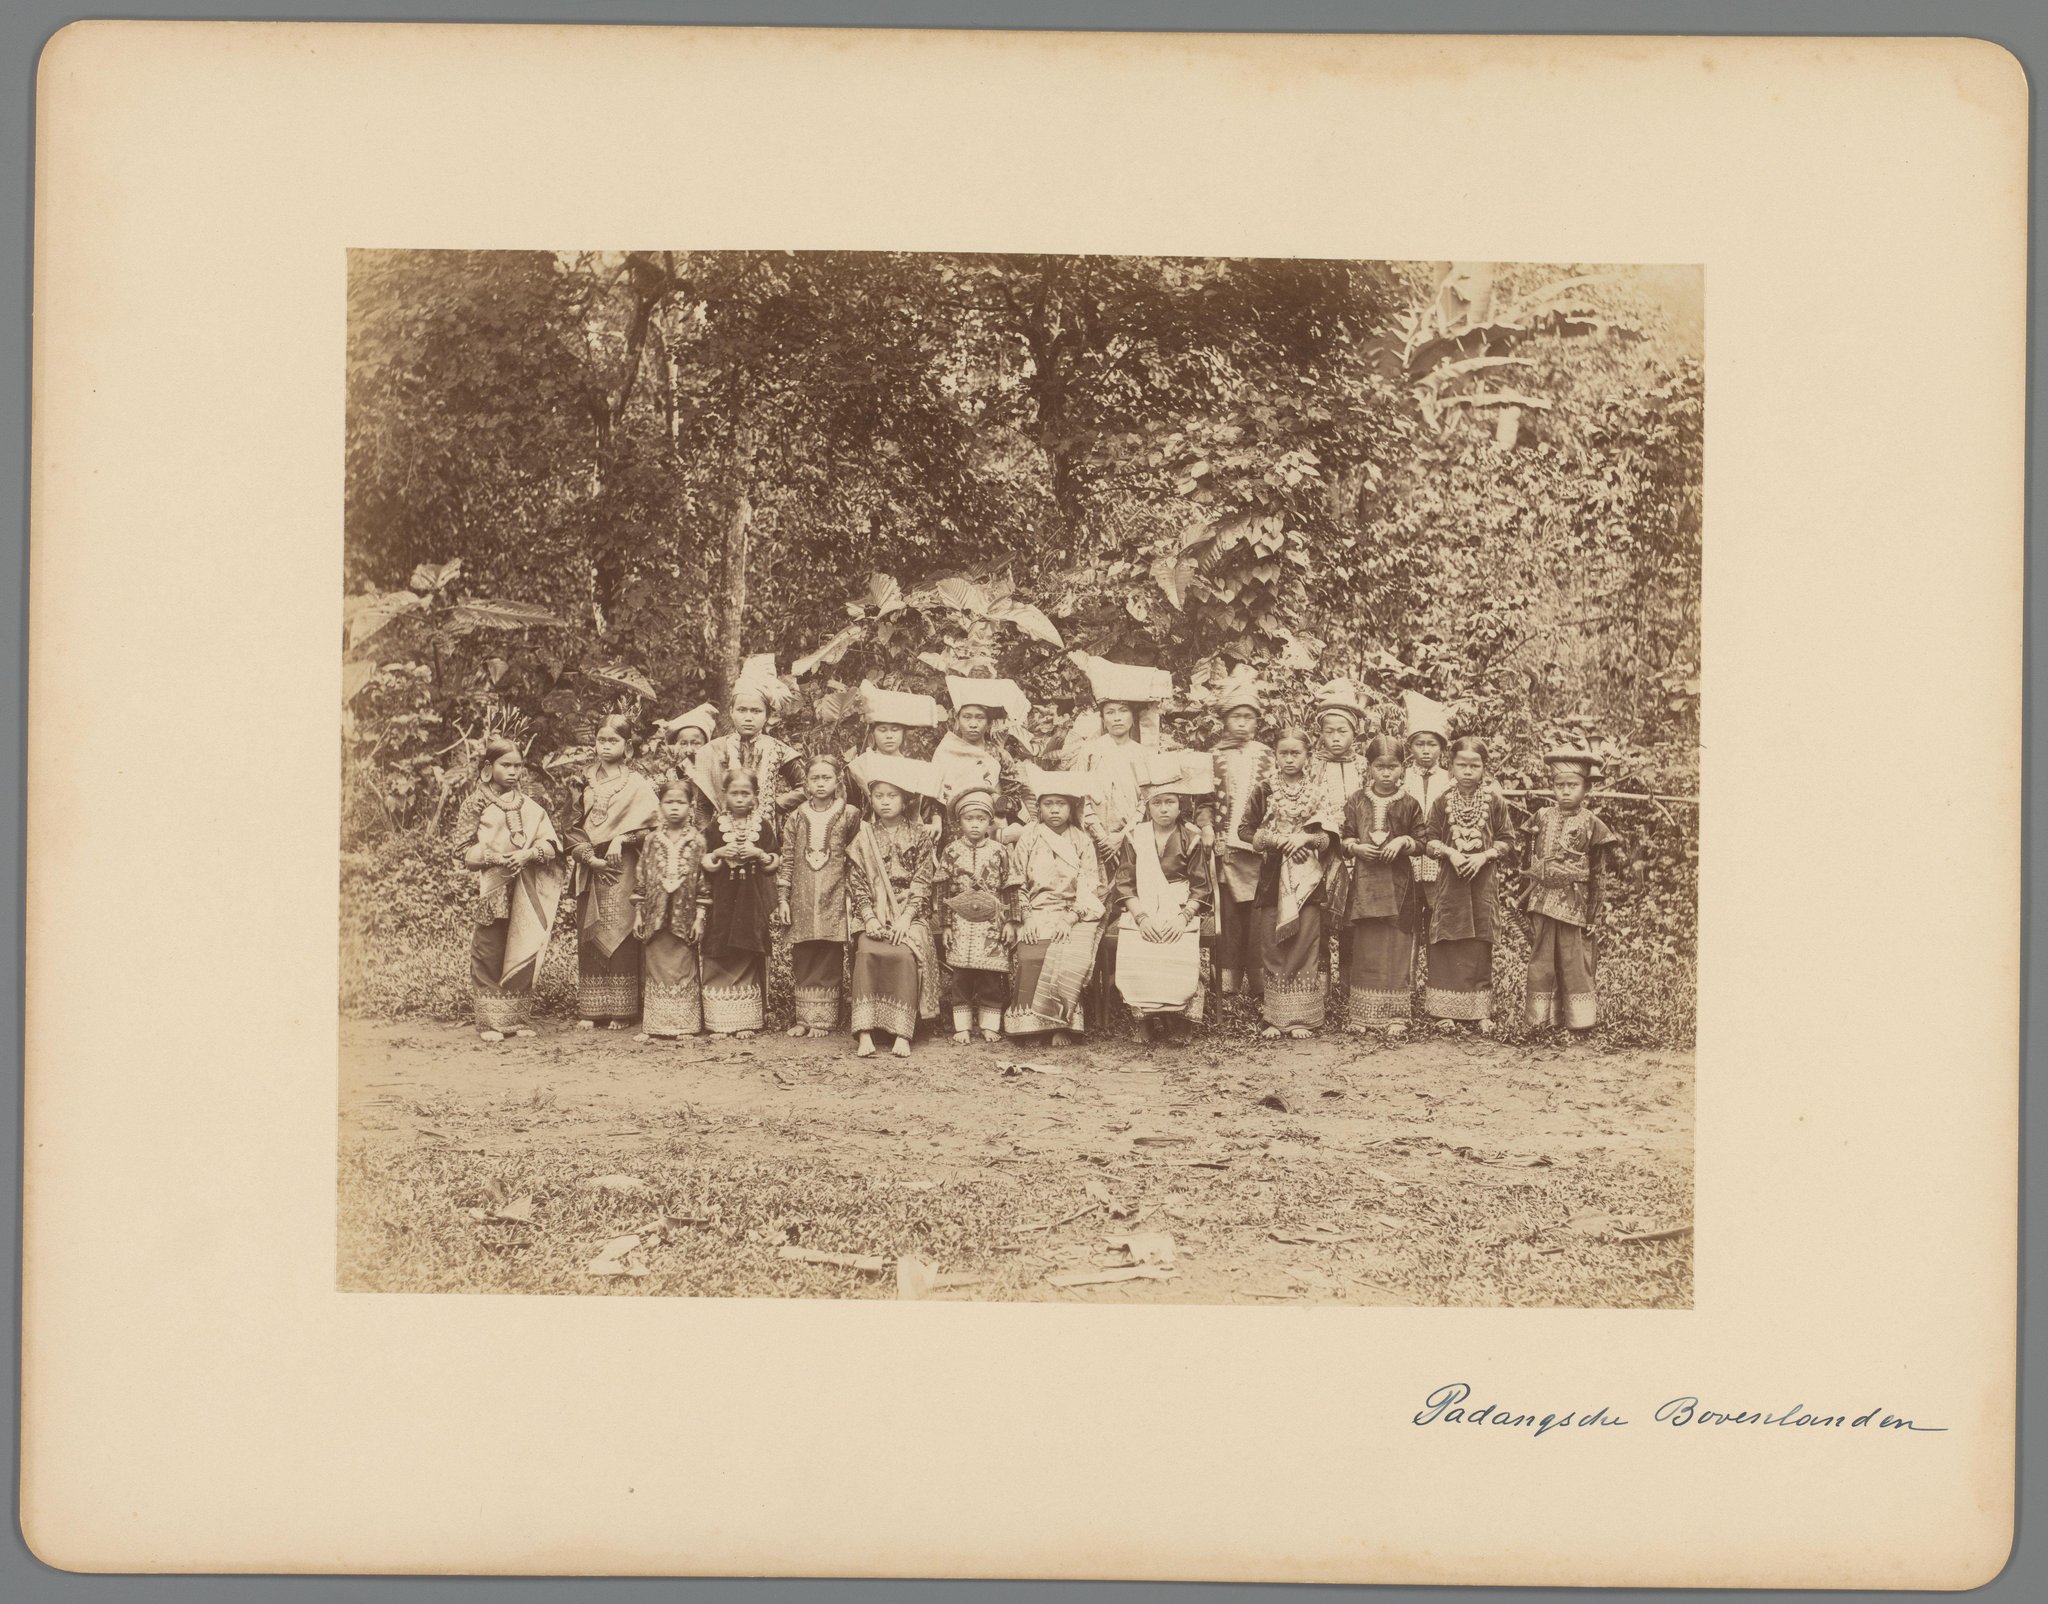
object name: photograph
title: Groepsportret van onbekende meisjes in klederdracht, West-Sumatra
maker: christiaan benjamin nieuwenhuis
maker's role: publisher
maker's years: 1863-1922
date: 1891-1895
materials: cardboard, paper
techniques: albumen print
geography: sumatera barat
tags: folk costume, regional costume, anonymous historical persons portrayed in a group, in a group-portrait, sumatera barat (province)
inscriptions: inscription: ‘Foto’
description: Deze foto zat oorspronkelijk in prentenkabinet RP-F-AA3192.